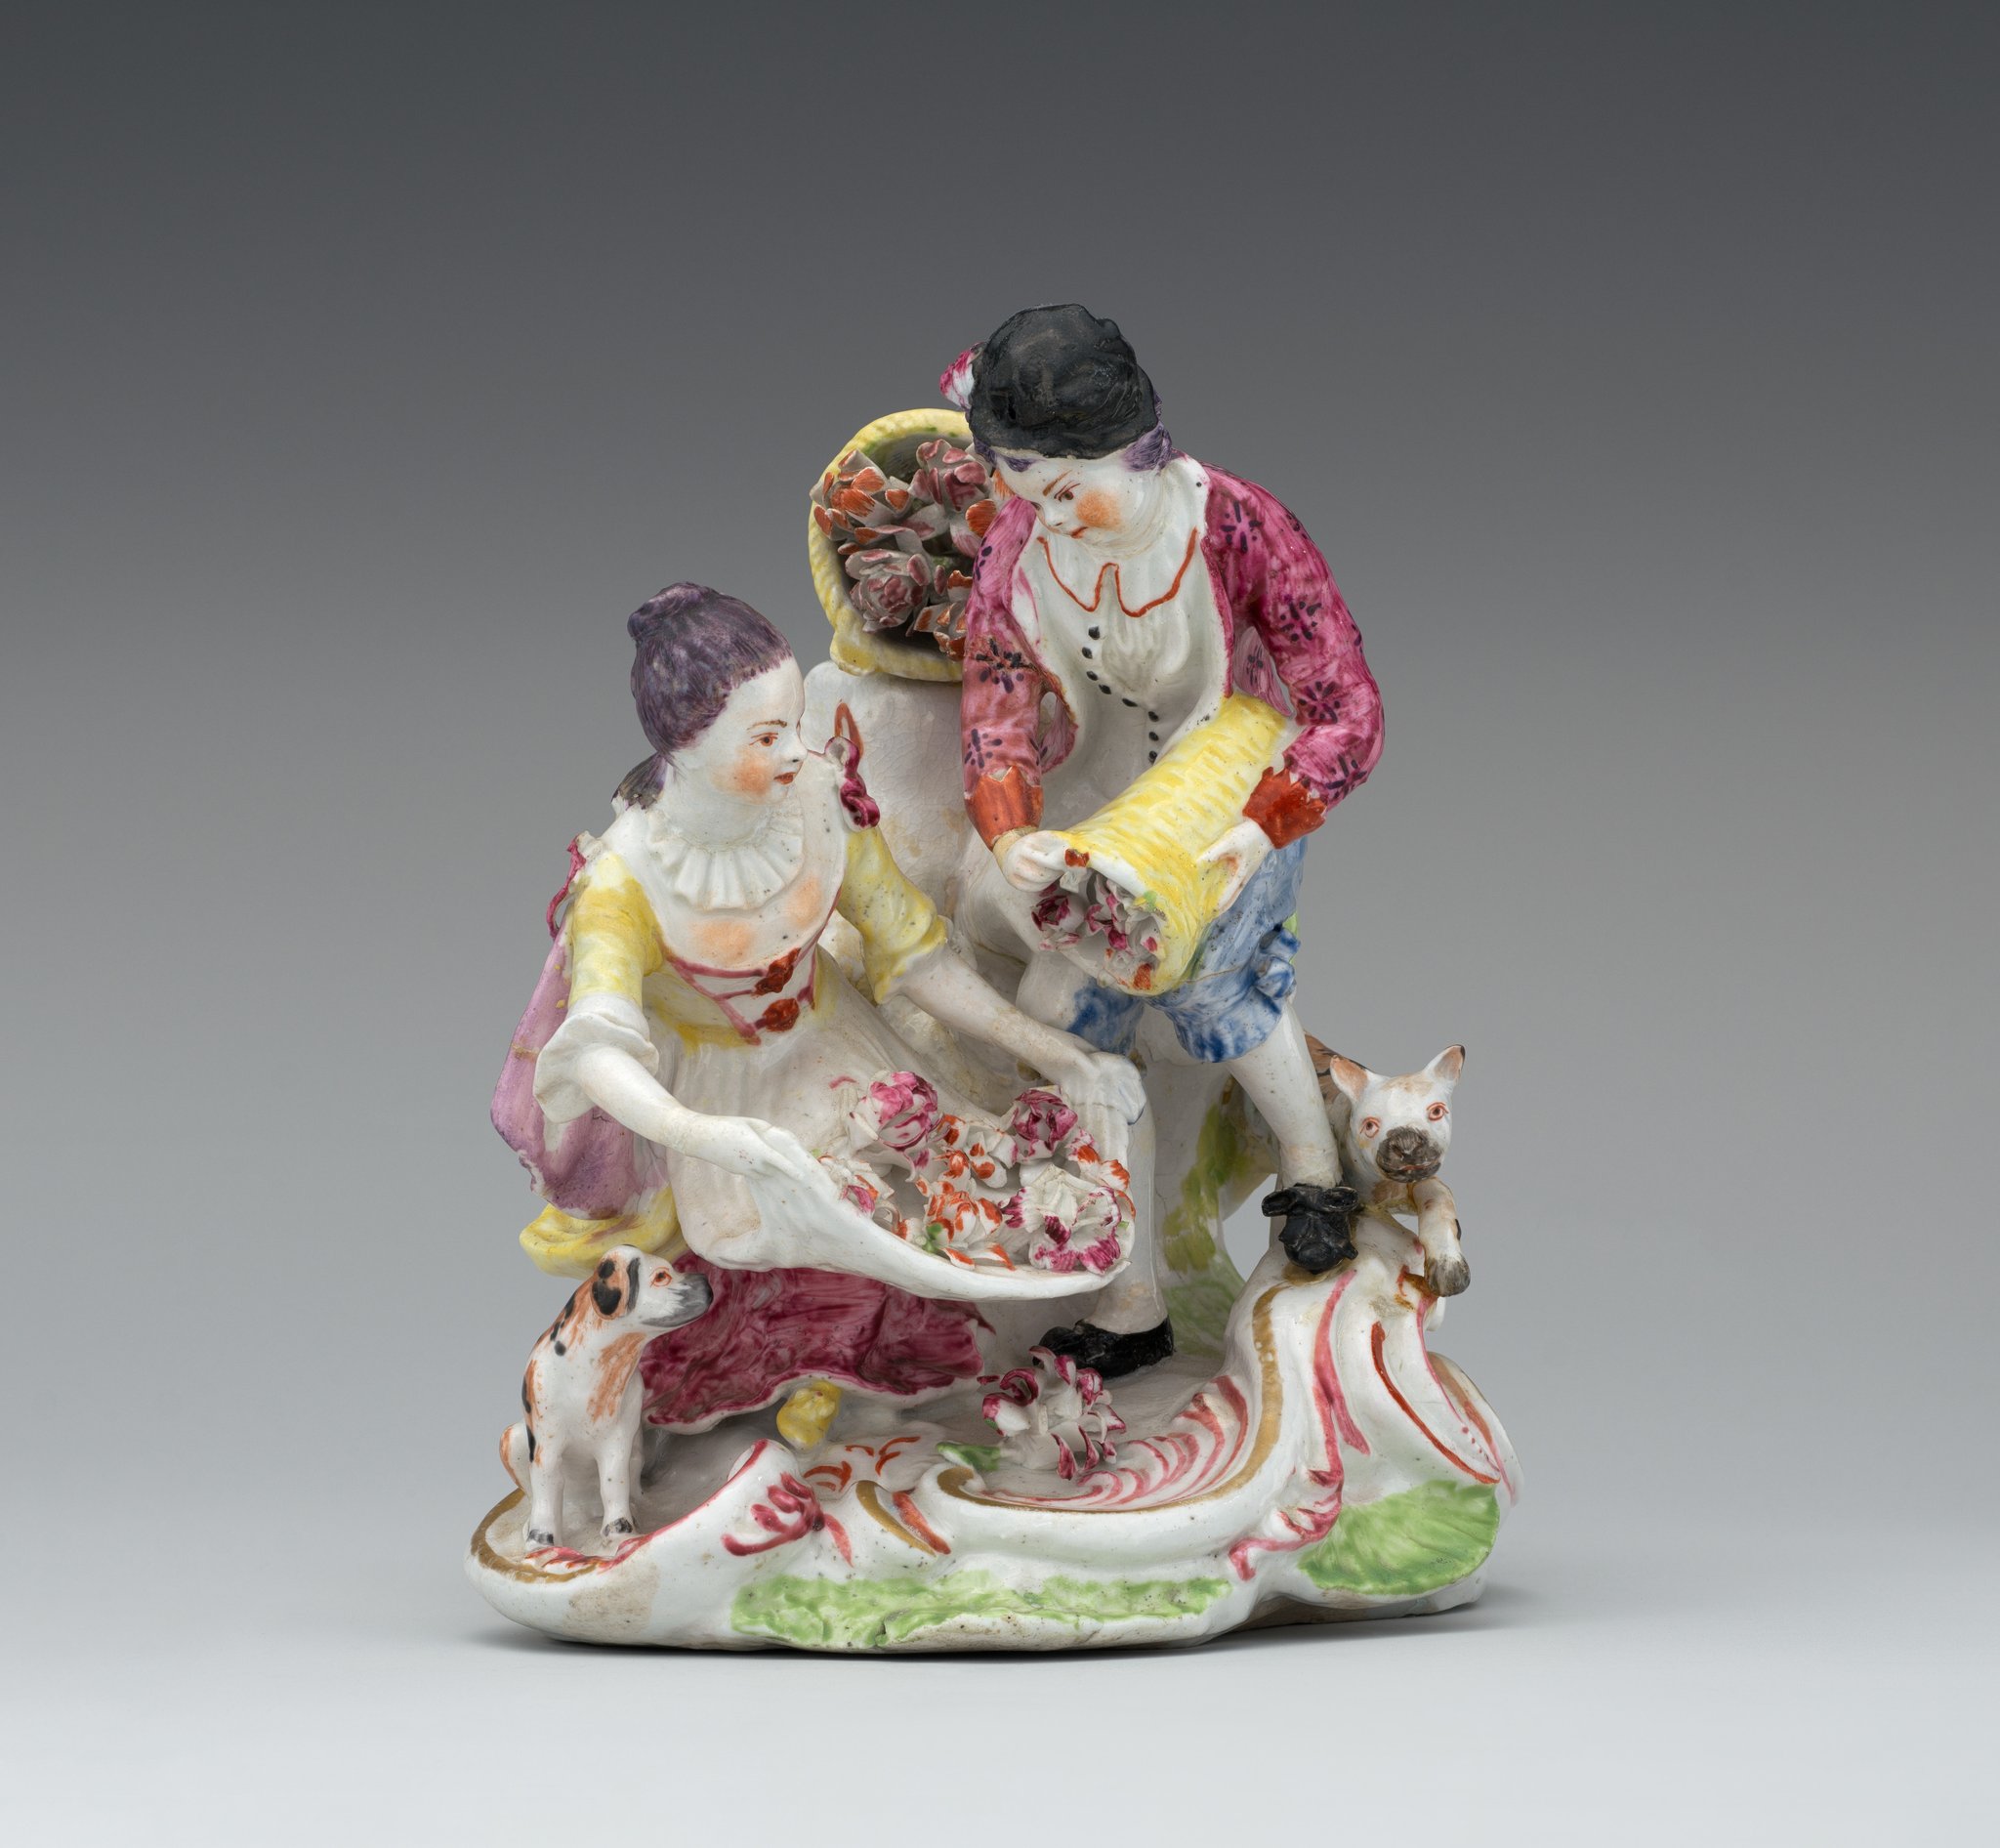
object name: group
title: Gardeners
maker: longton hall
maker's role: factory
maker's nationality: british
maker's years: 1744-1760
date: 1755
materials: soft paste porcelain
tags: animals,women,dogs,gardeners